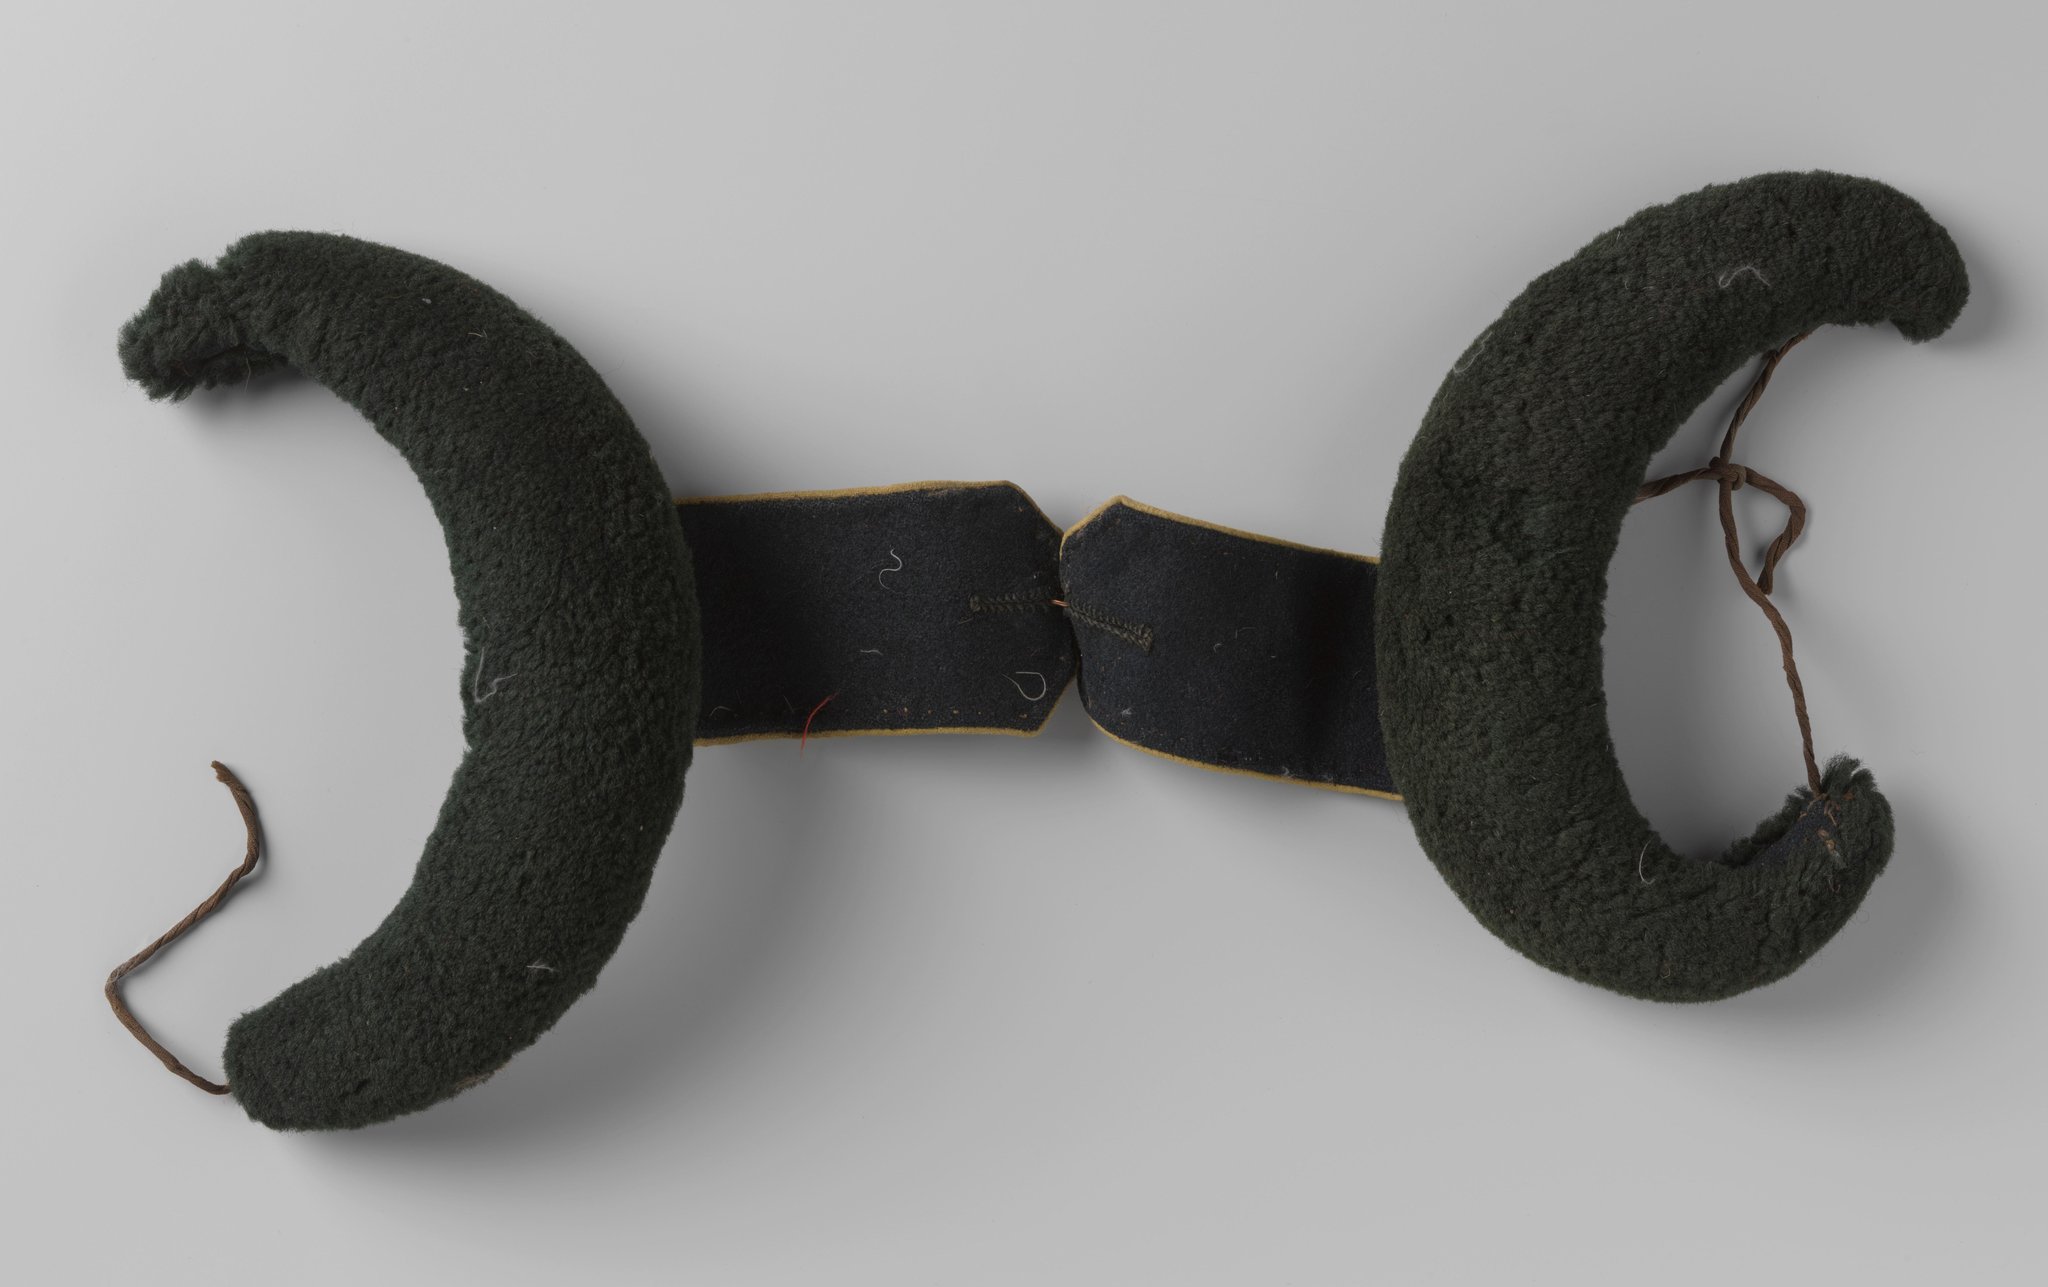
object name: shoulder loop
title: Wings voor vrijwillige jager, ca. 1830-1831.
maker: Anonymous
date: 1830-1831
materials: textile, metal, wool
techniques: stitching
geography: netherlands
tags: netherlands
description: Wings van groene wol met bruine katoenen veters, waaraan groene lakense schouderlap, welke geel gebiesd is. Hieraan haken ter bevestiging aan de schouders van de rok. Aan de epaulet een leren label met nummer 92 en een label met NM 10385-92 Roosdorp.